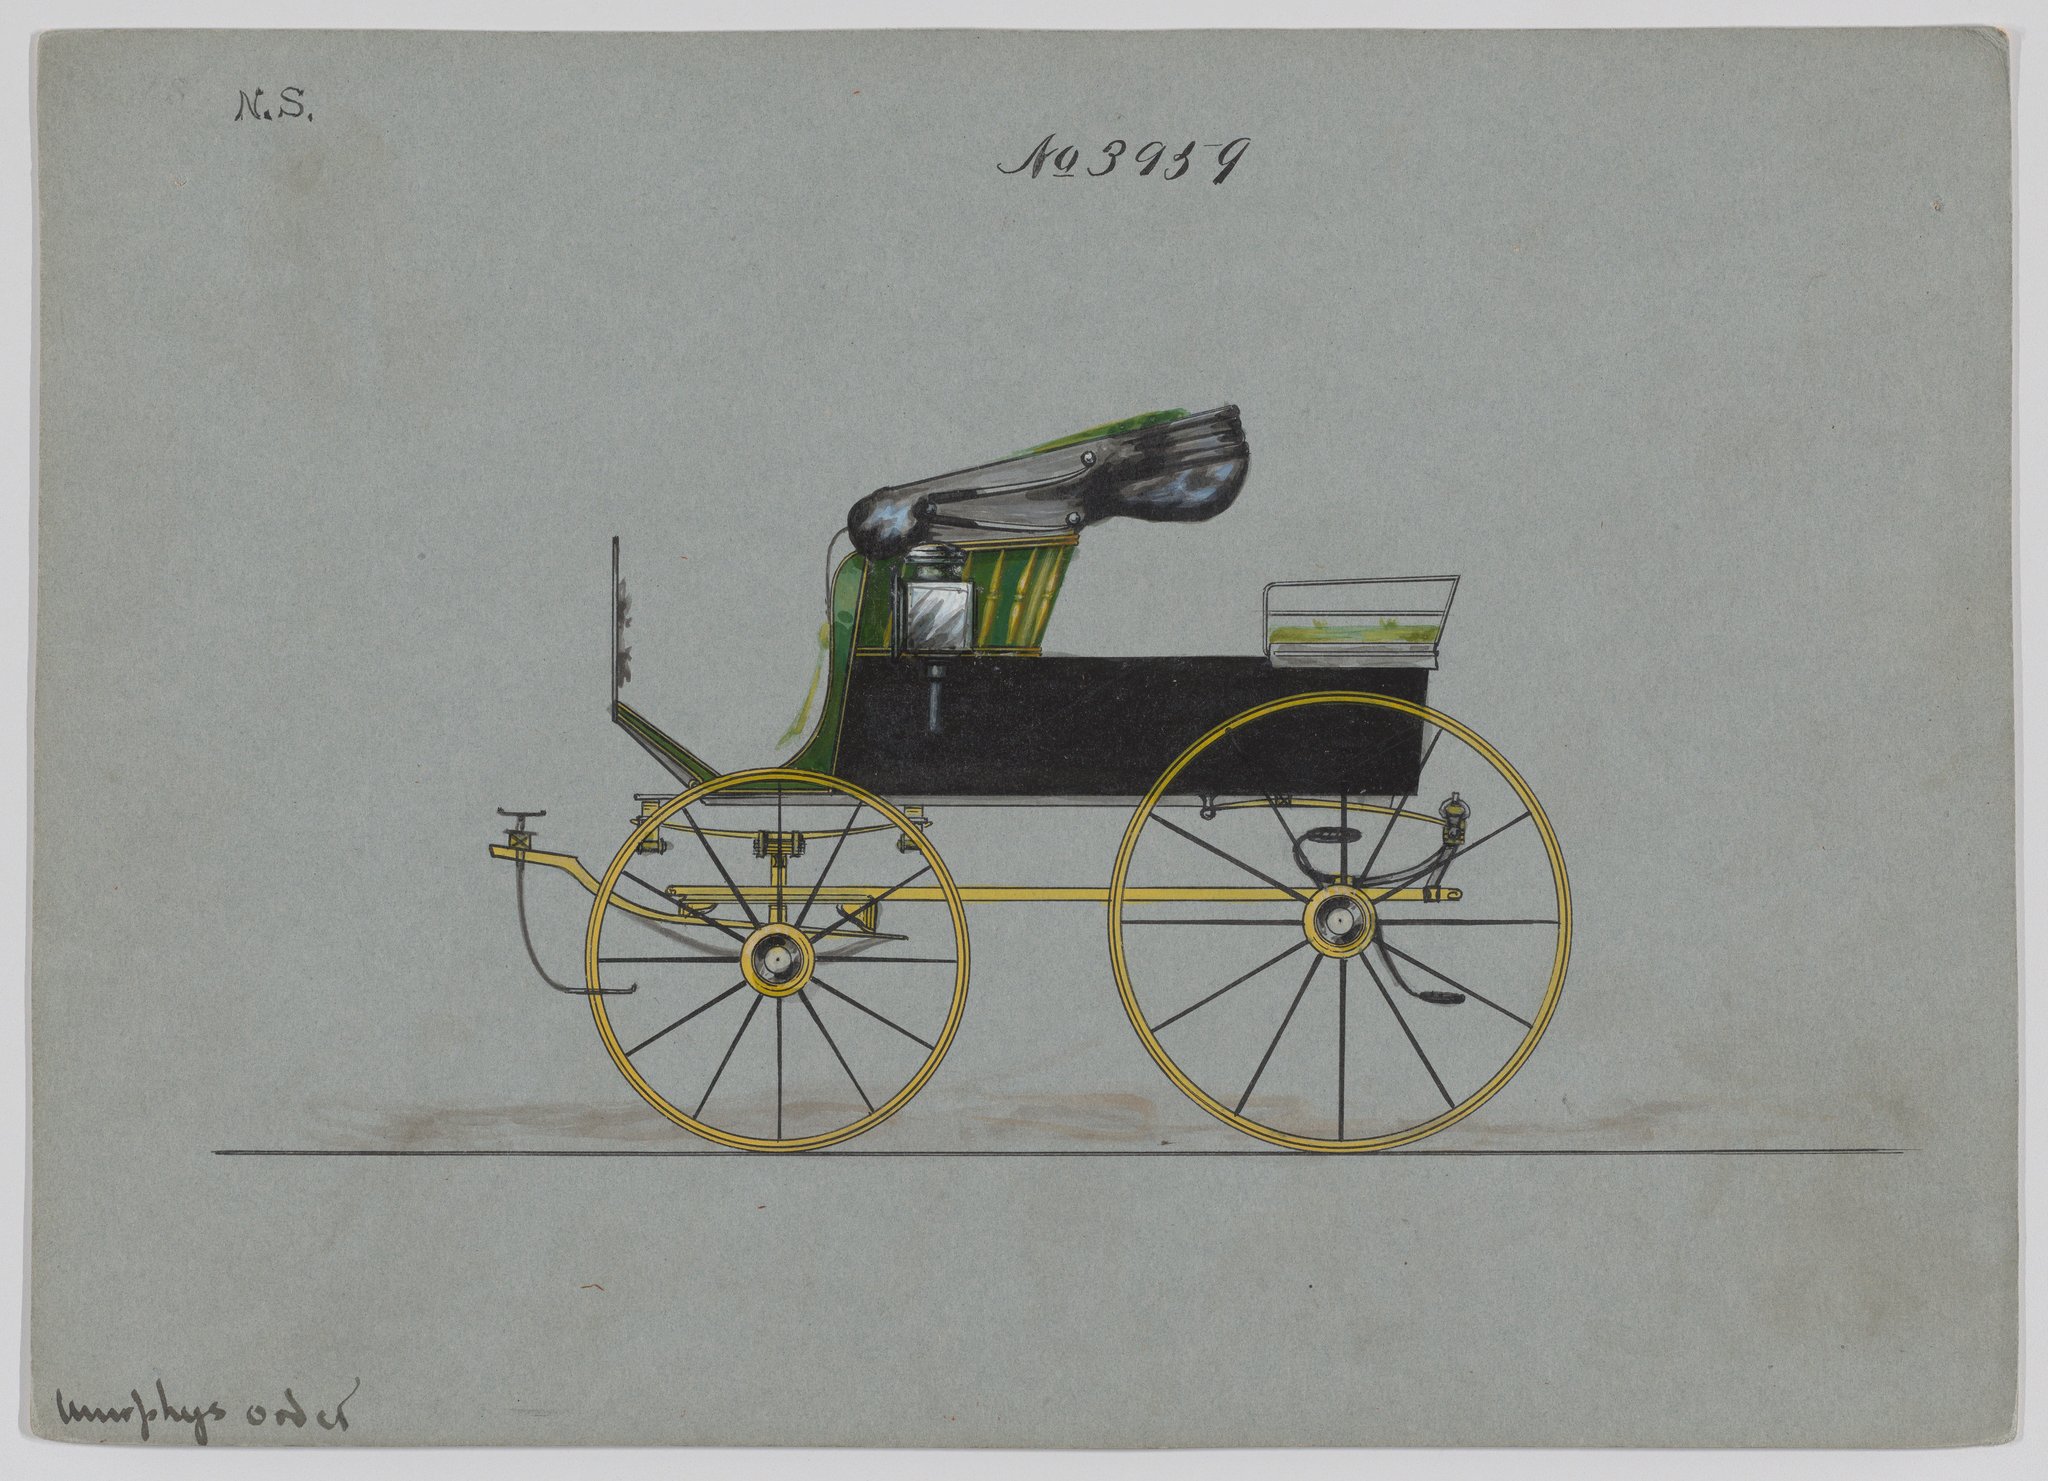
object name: drawing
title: Design for Stanhope Phaeton, no. 3959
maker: brewster & co.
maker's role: manufacturer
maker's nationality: american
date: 1885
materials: ink, watercolor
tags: carriages